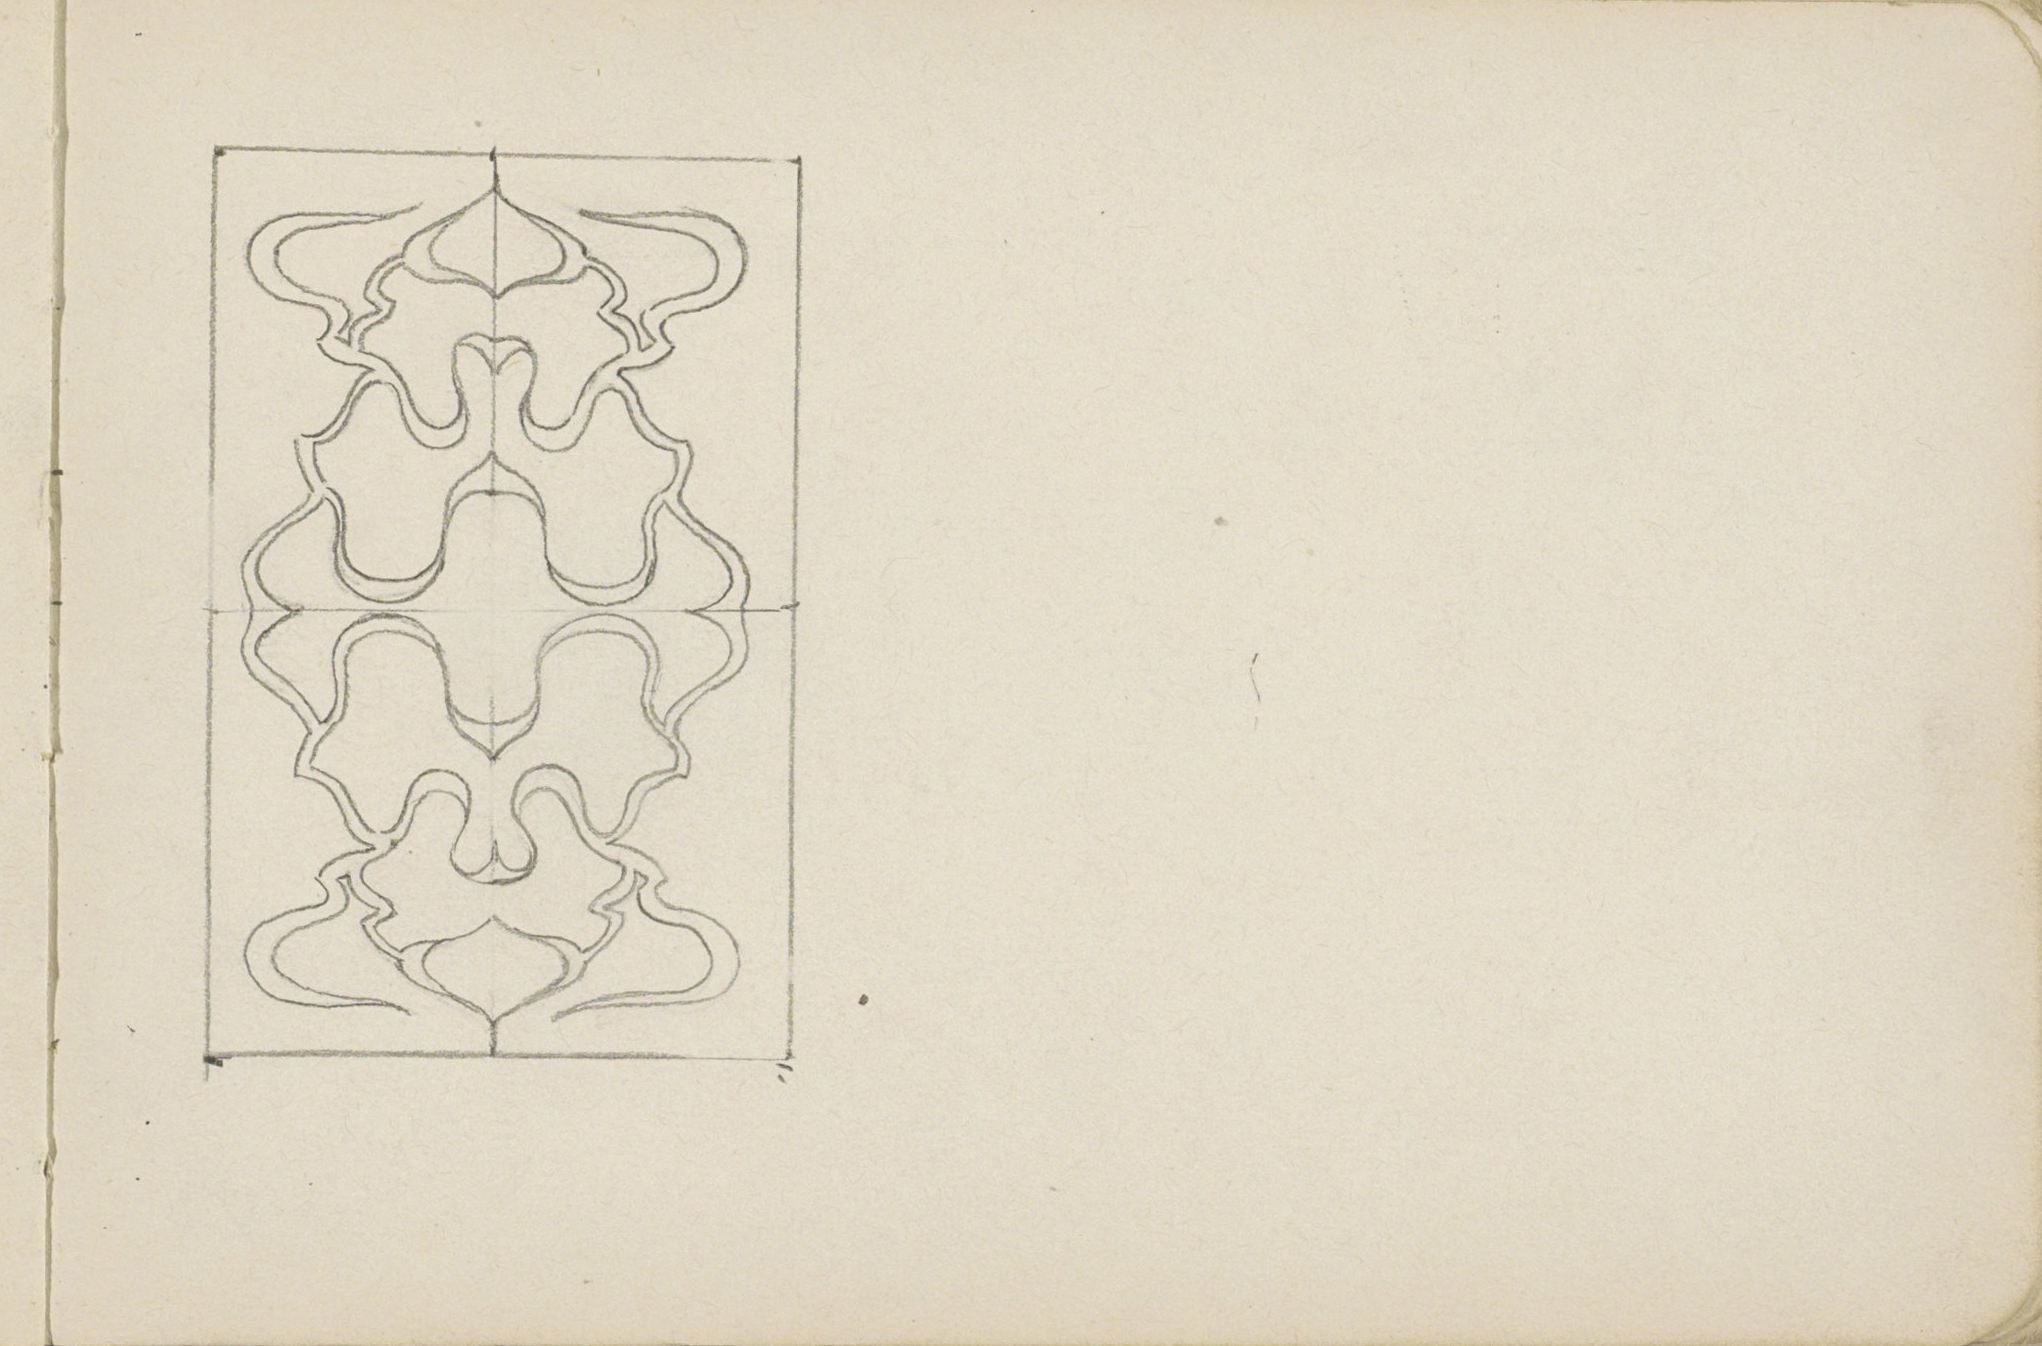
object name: sketchbook leaf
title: Symmetrisch patroon van krullende lijnen binnen een rechthoek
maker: julie de graag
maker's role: draughtsman, print maker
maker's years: 1877-1924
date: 1894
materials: paper, pencil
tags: ornaments ~ art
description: Blad 6 recto uit een schetsboek met 35 bladen.